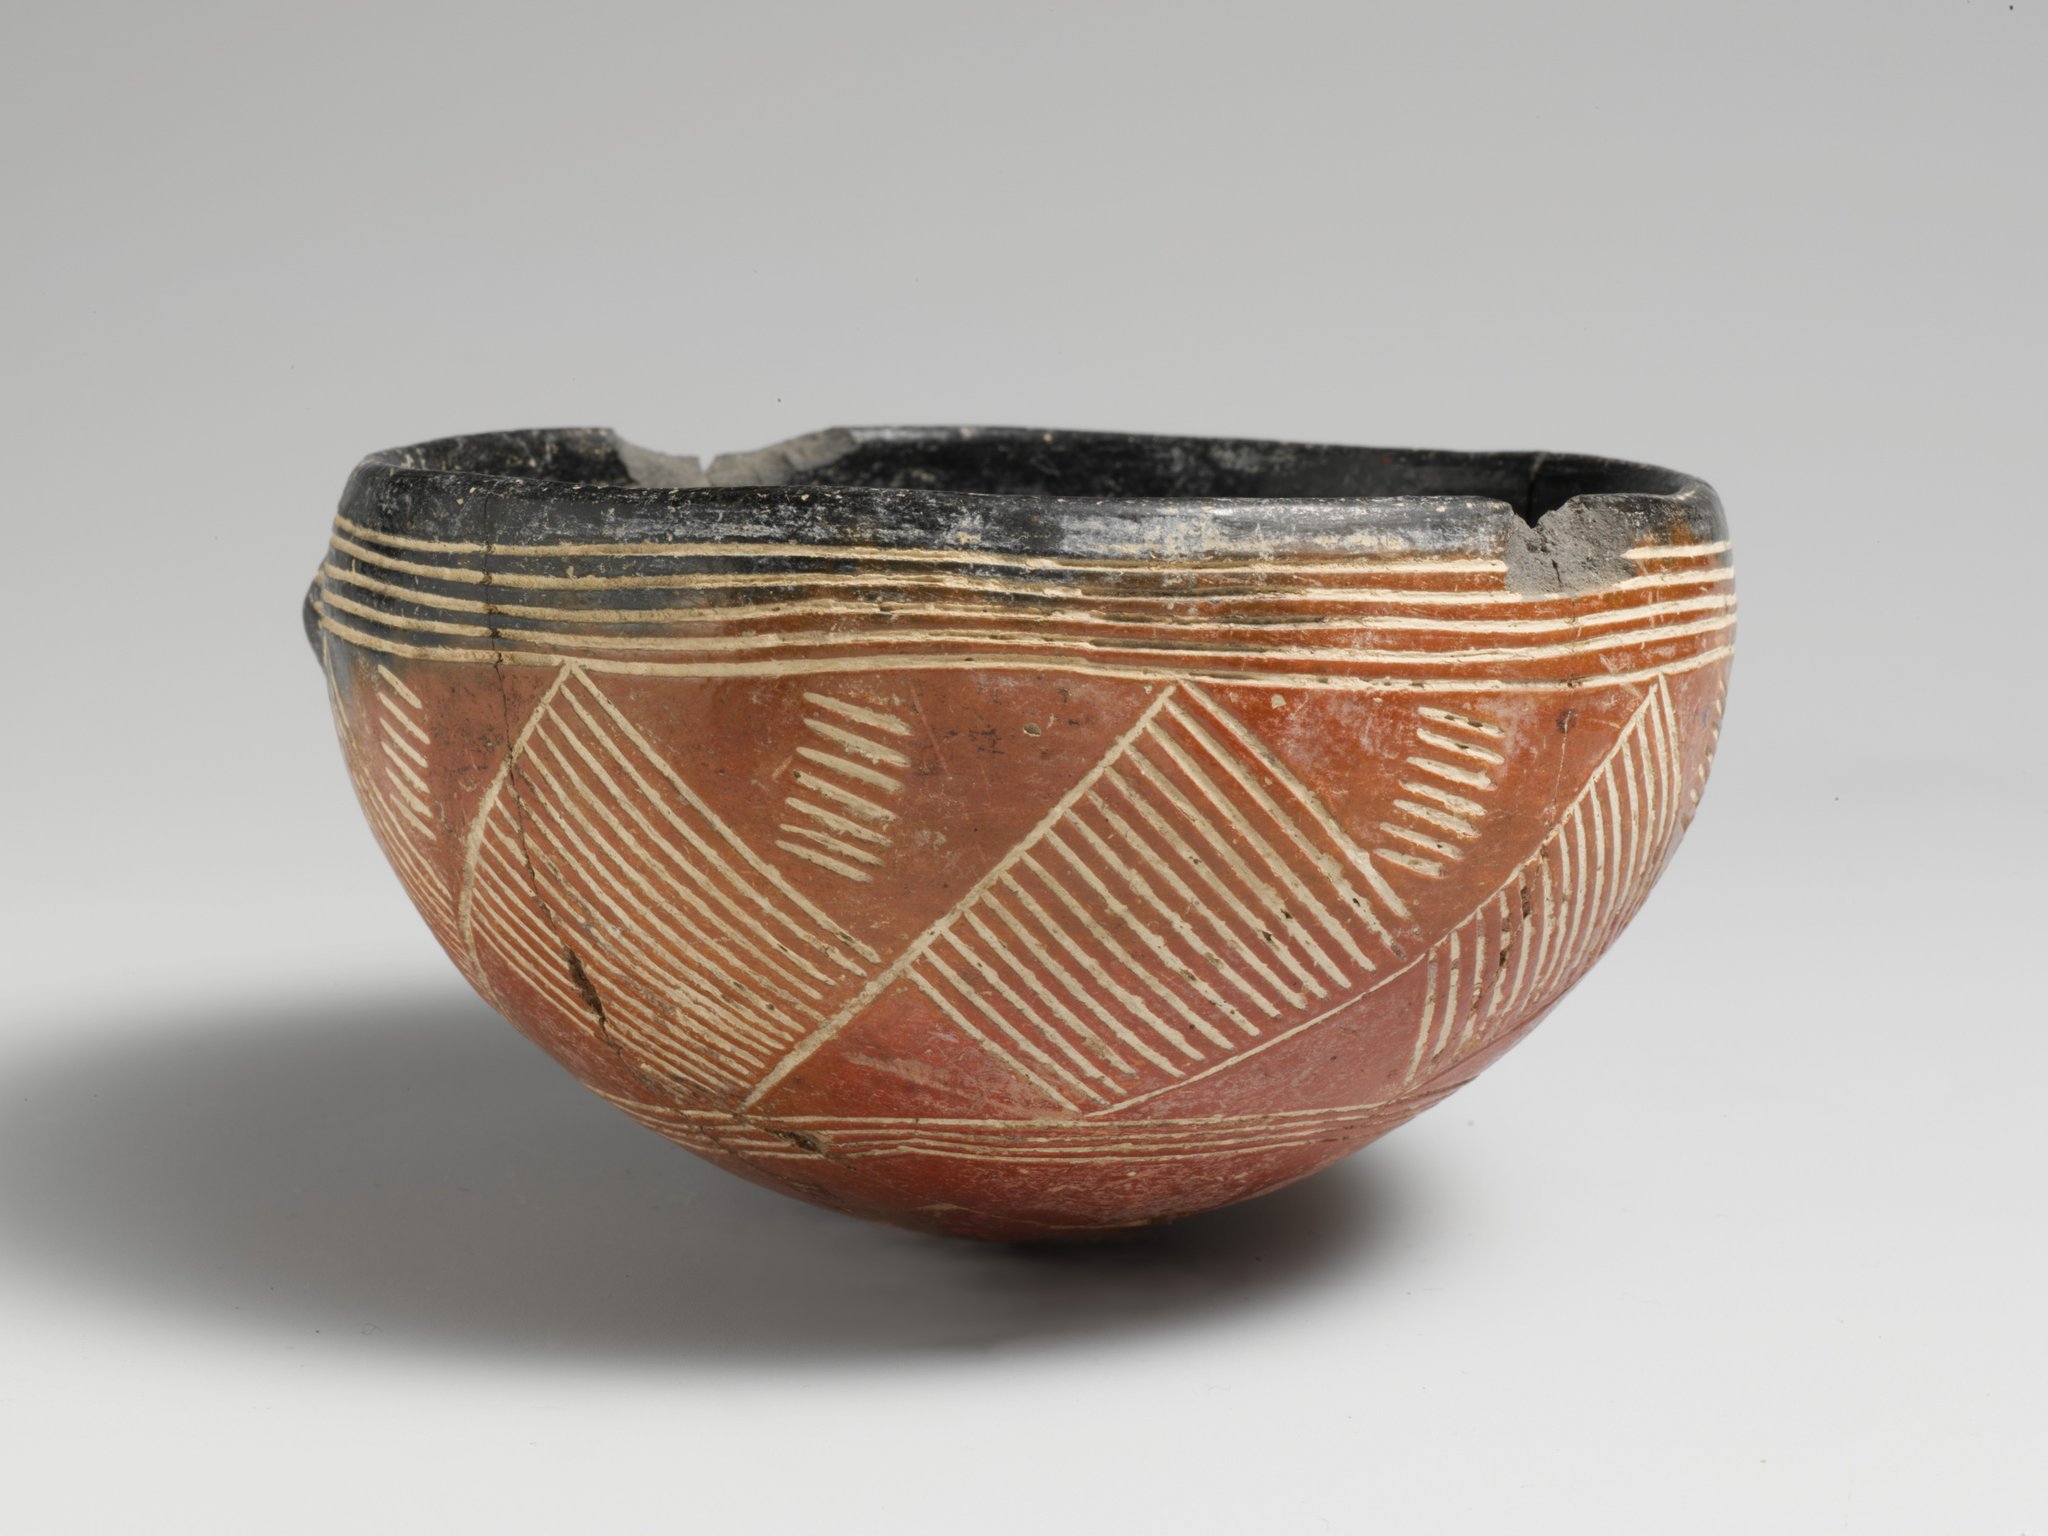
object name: bowl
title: Terracotta bowl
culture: cypriot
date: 2500-1900 BCE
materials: terracotta